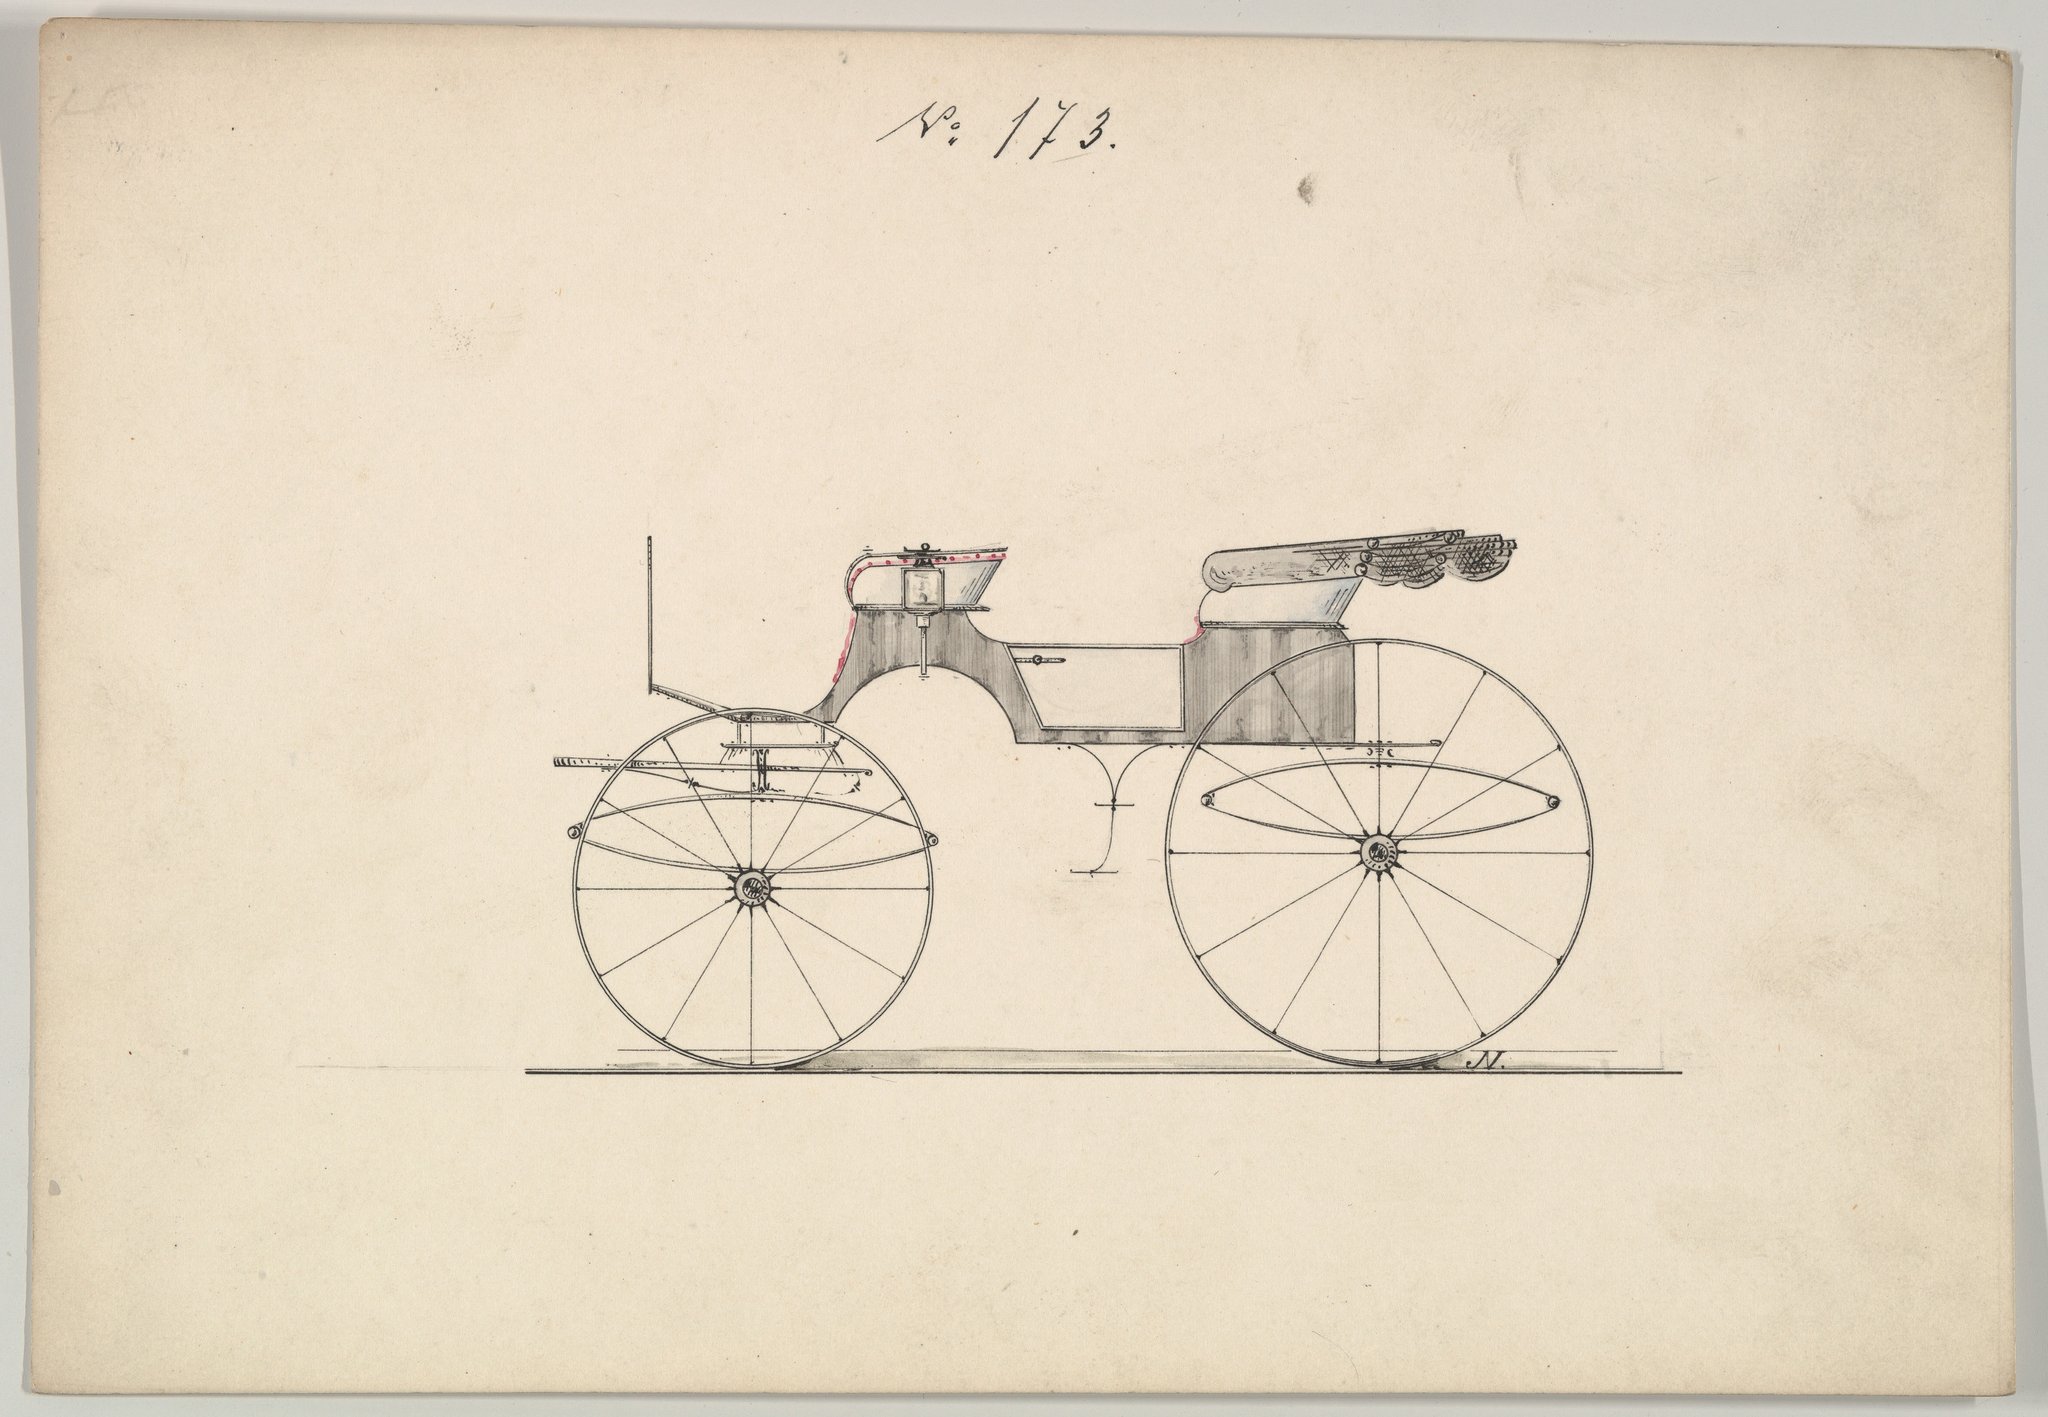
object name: drawing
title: Design for Phaeton, no. 173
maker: brewster & co.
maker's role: manufacturer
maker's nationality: american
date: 1850-1874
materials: gouache, ink, watercolor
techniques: pen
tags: carriages